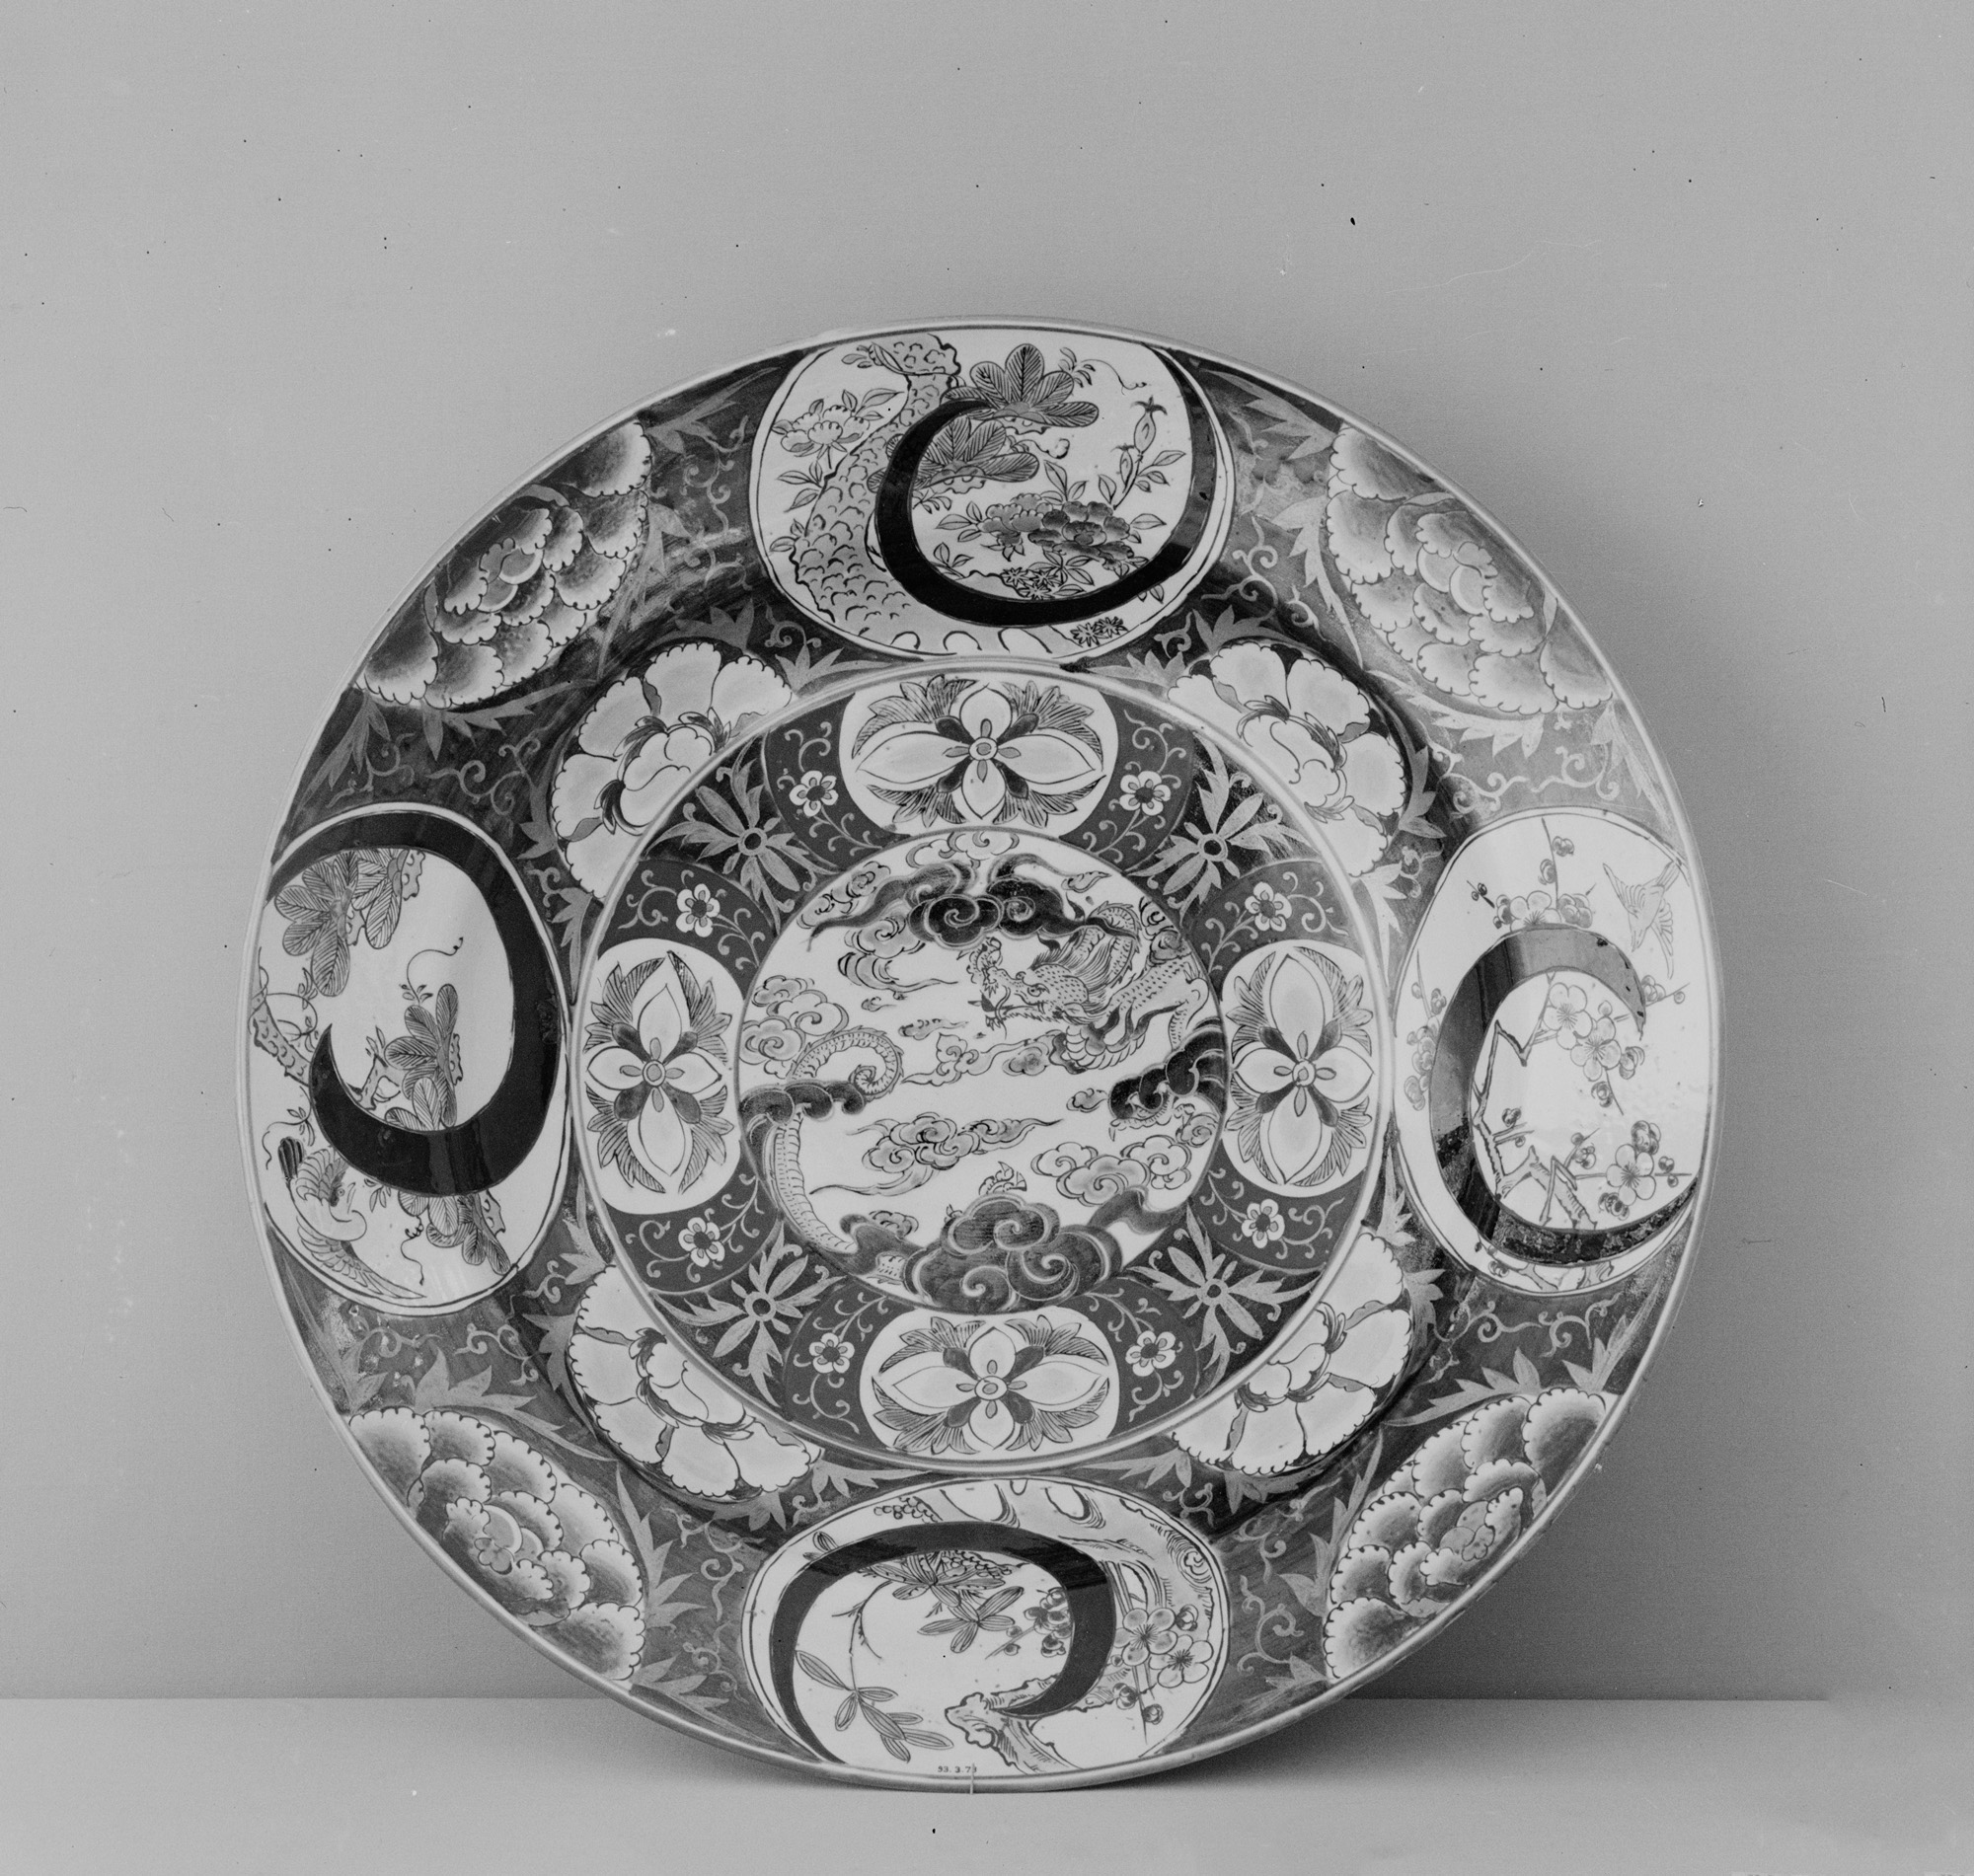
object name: dish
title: Large Dish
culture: japanese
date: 1720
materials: enamel, glaze, porcelain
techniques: polychrome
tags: dragons,flowers